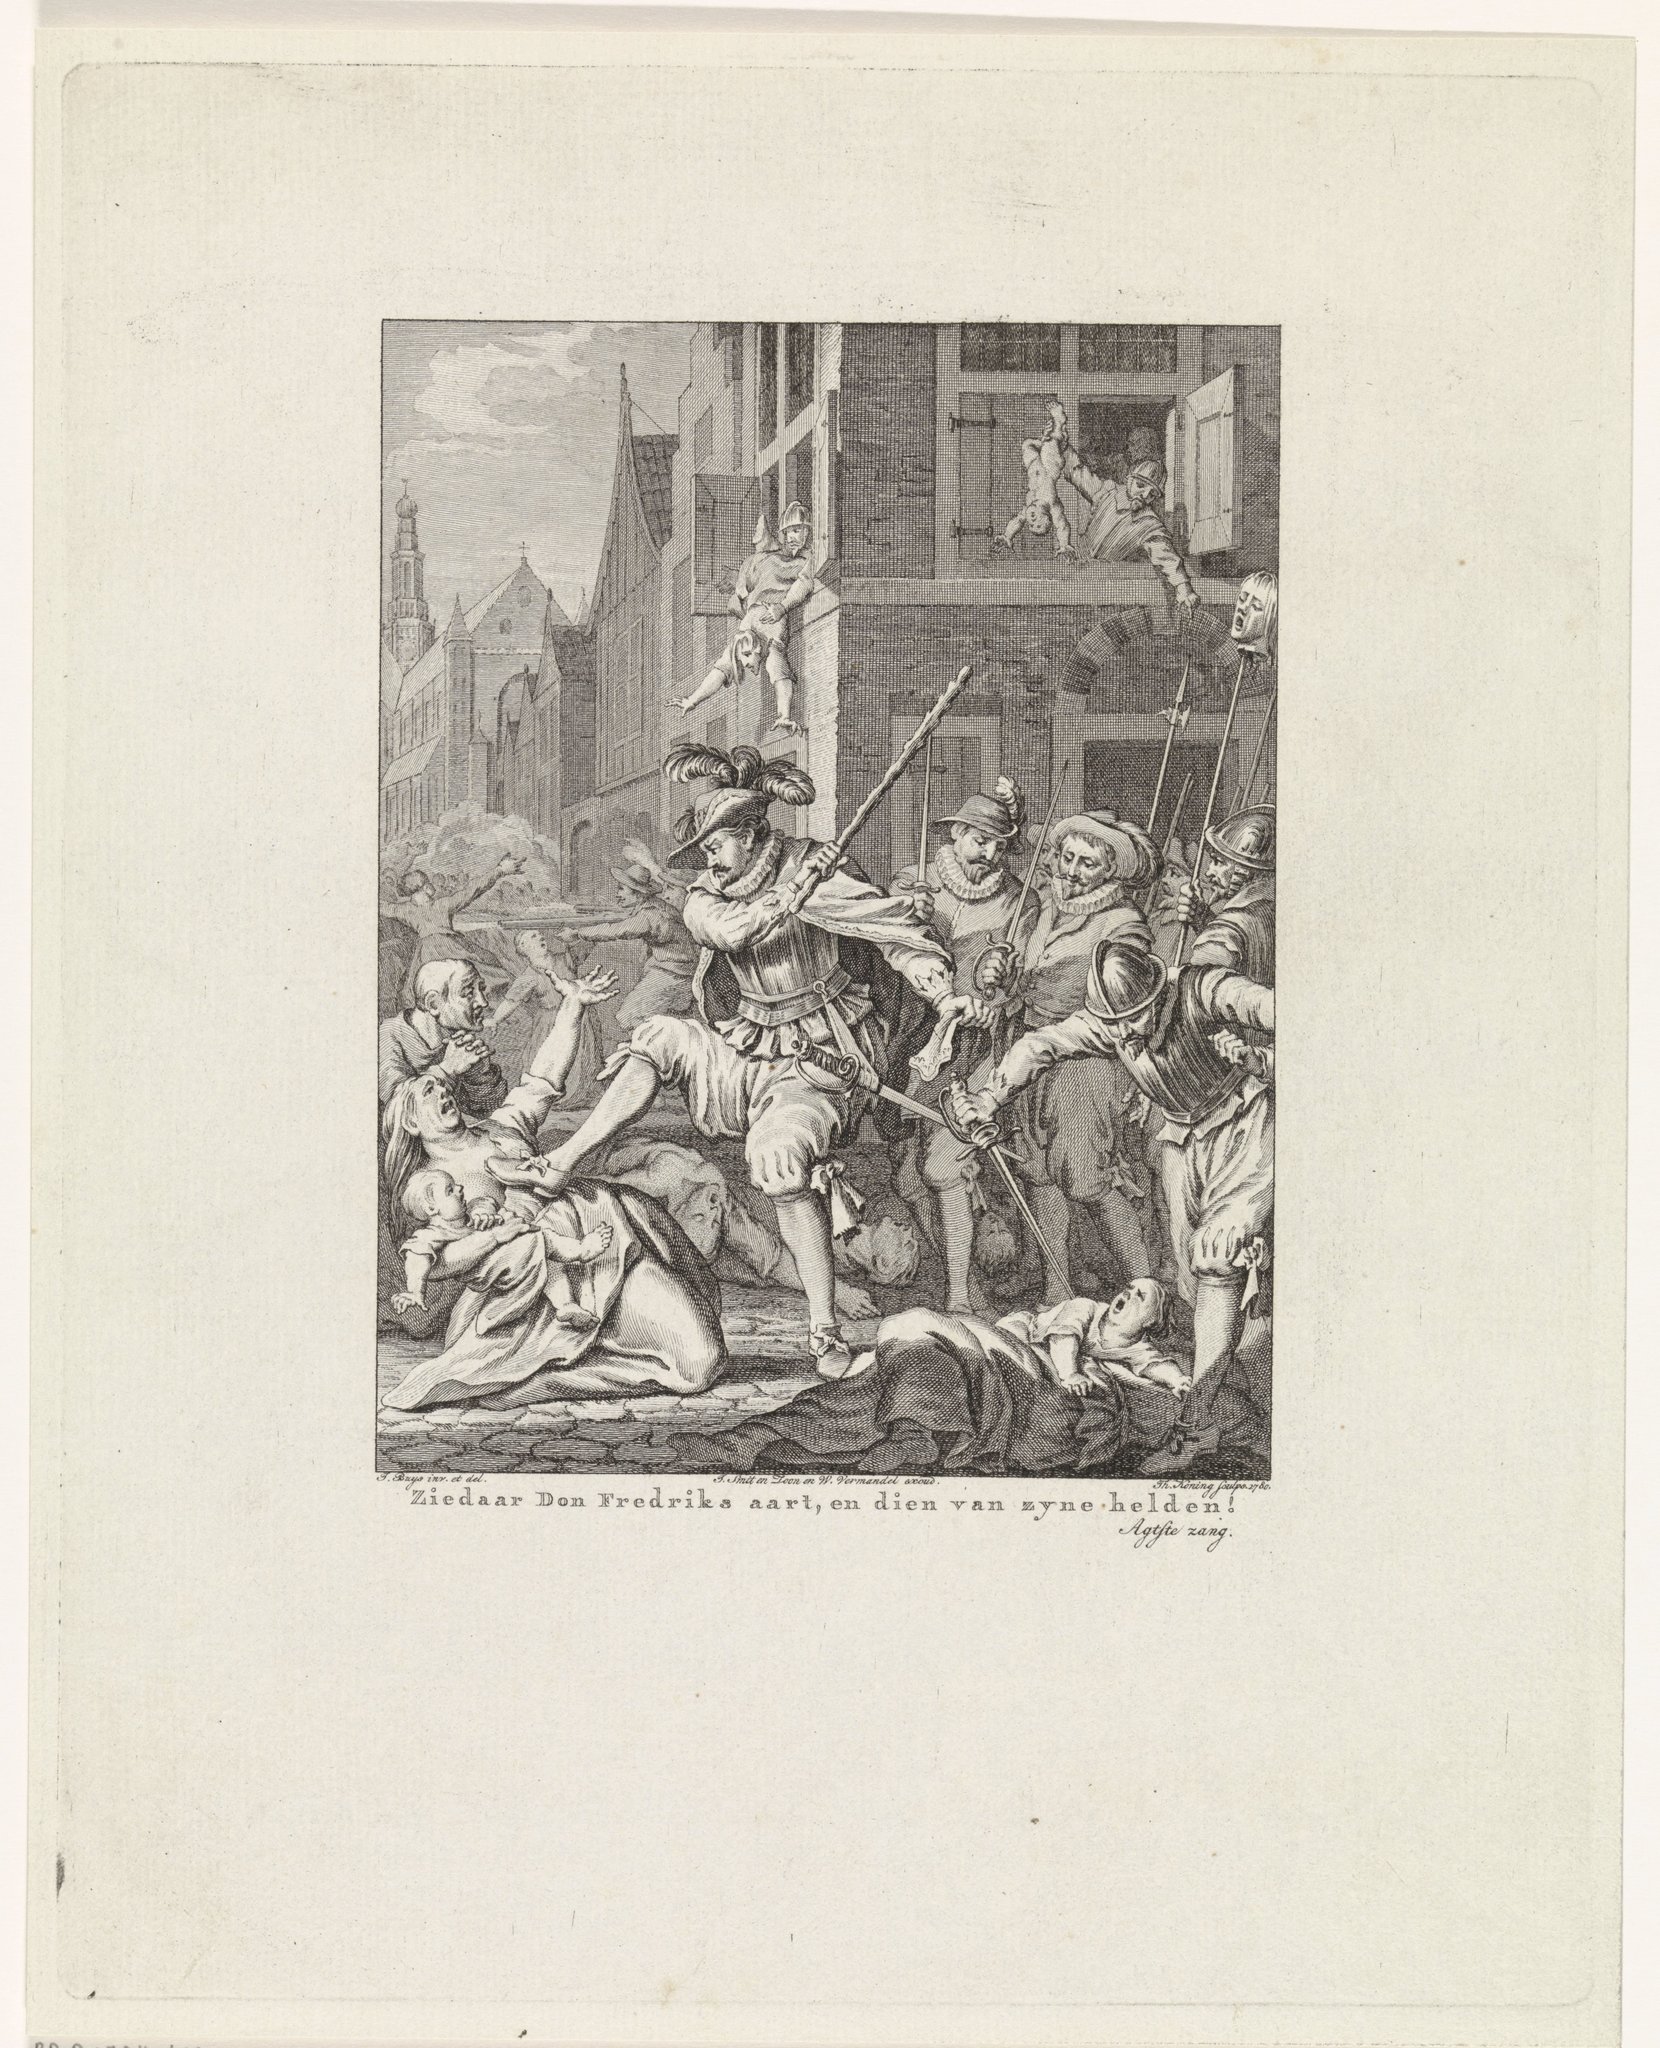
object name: history print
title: Taferelen uit het leven van prins Willem I, 1568-1584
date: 1780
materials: paper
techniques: engraving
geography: amsterdam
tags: massacre ~ war, haarlem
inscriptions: collector's mark: Lugt 2228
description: Moordpartij aangericht door Don Frederik en de Spaanse soldaten te Haarlem, 1573. Op de voorgrond dreigt Don Frederik een vrouw met kind en een biddende monnik af te ranselen. Achter Don Frederik bevindt zich een groep moordende Spaanse soldaten, waarvan er één het hoofd van een vrouw op zijn lans heeft geprikt. Vanuit een huis worden een vrouw en een kind uit het venster gegooid. Op de achtergrond is de Sint-Bavokerk te zien. Deze prent maakt deel uit van een serie van 24 prenten met taferelen uit het leven van prins Willem I, 1568-1584 en is een illustratie bij de achtste zang.